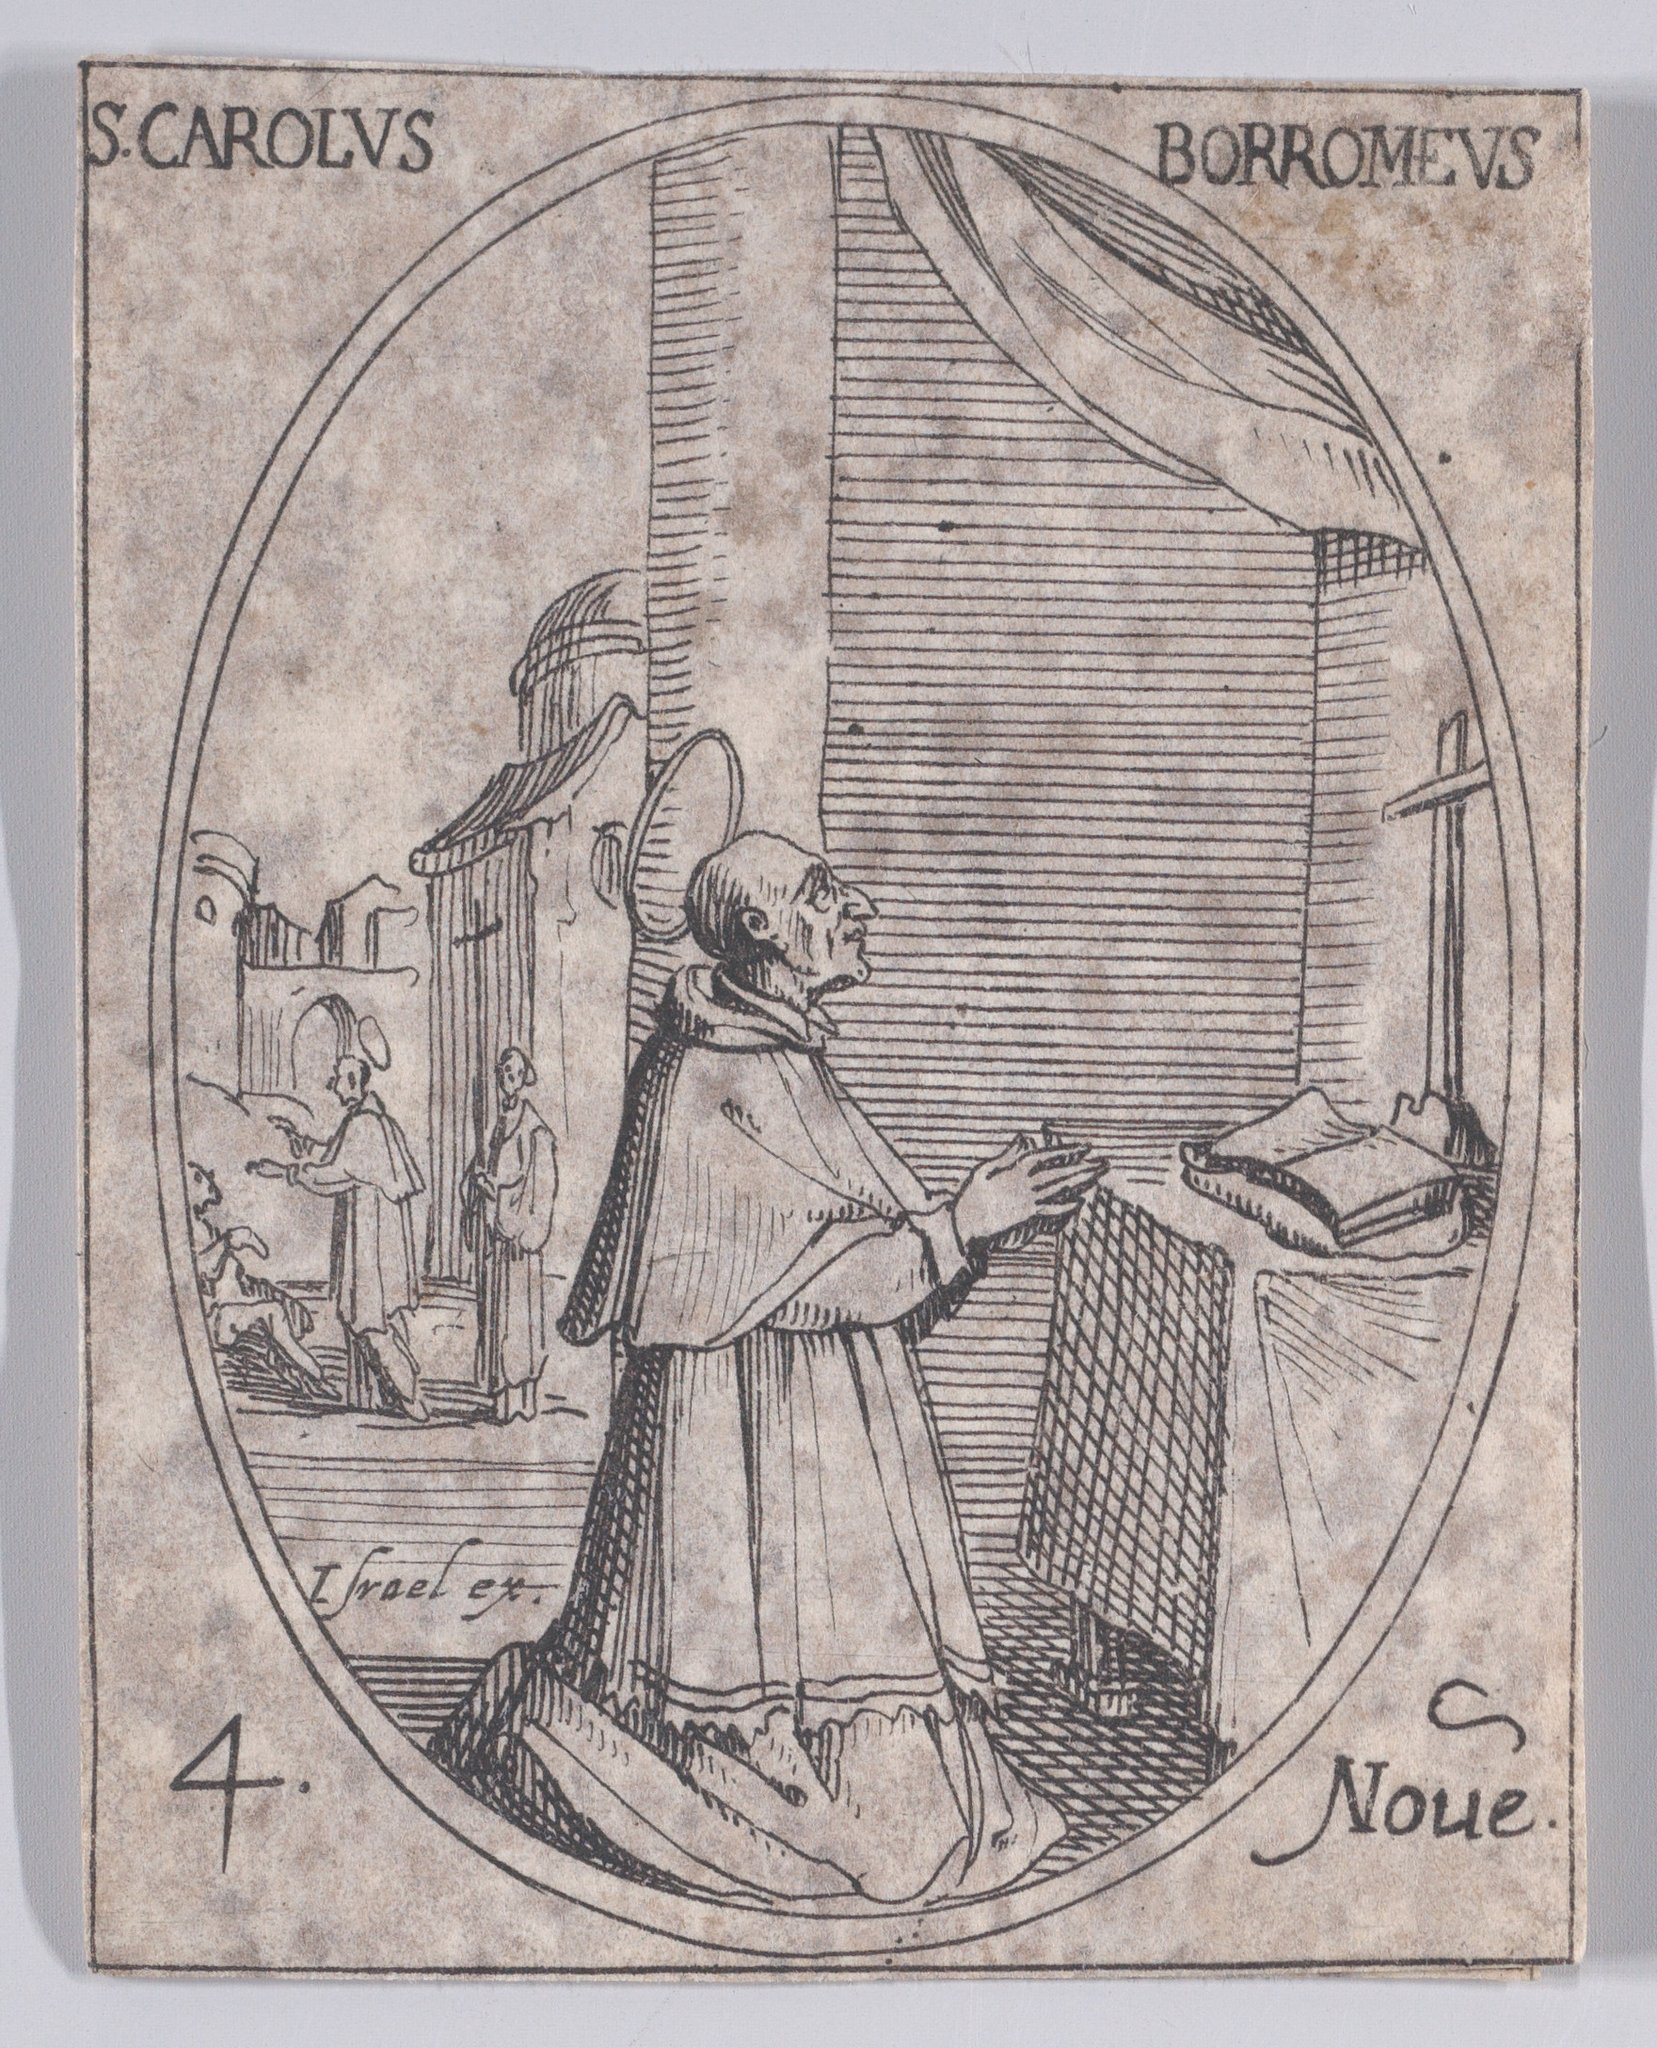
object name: print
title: S. Charles Borromée (St. Charles Borommeo), from November 4th, from "Les Images De Tous Les Saincts et Saintes de L'Année" (Images of All of the Saints and Religious Events of the Year)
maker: jacques callot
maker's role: artist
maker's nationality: french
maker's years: 1592-1635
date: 1636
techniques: etching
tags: altars,men,saints